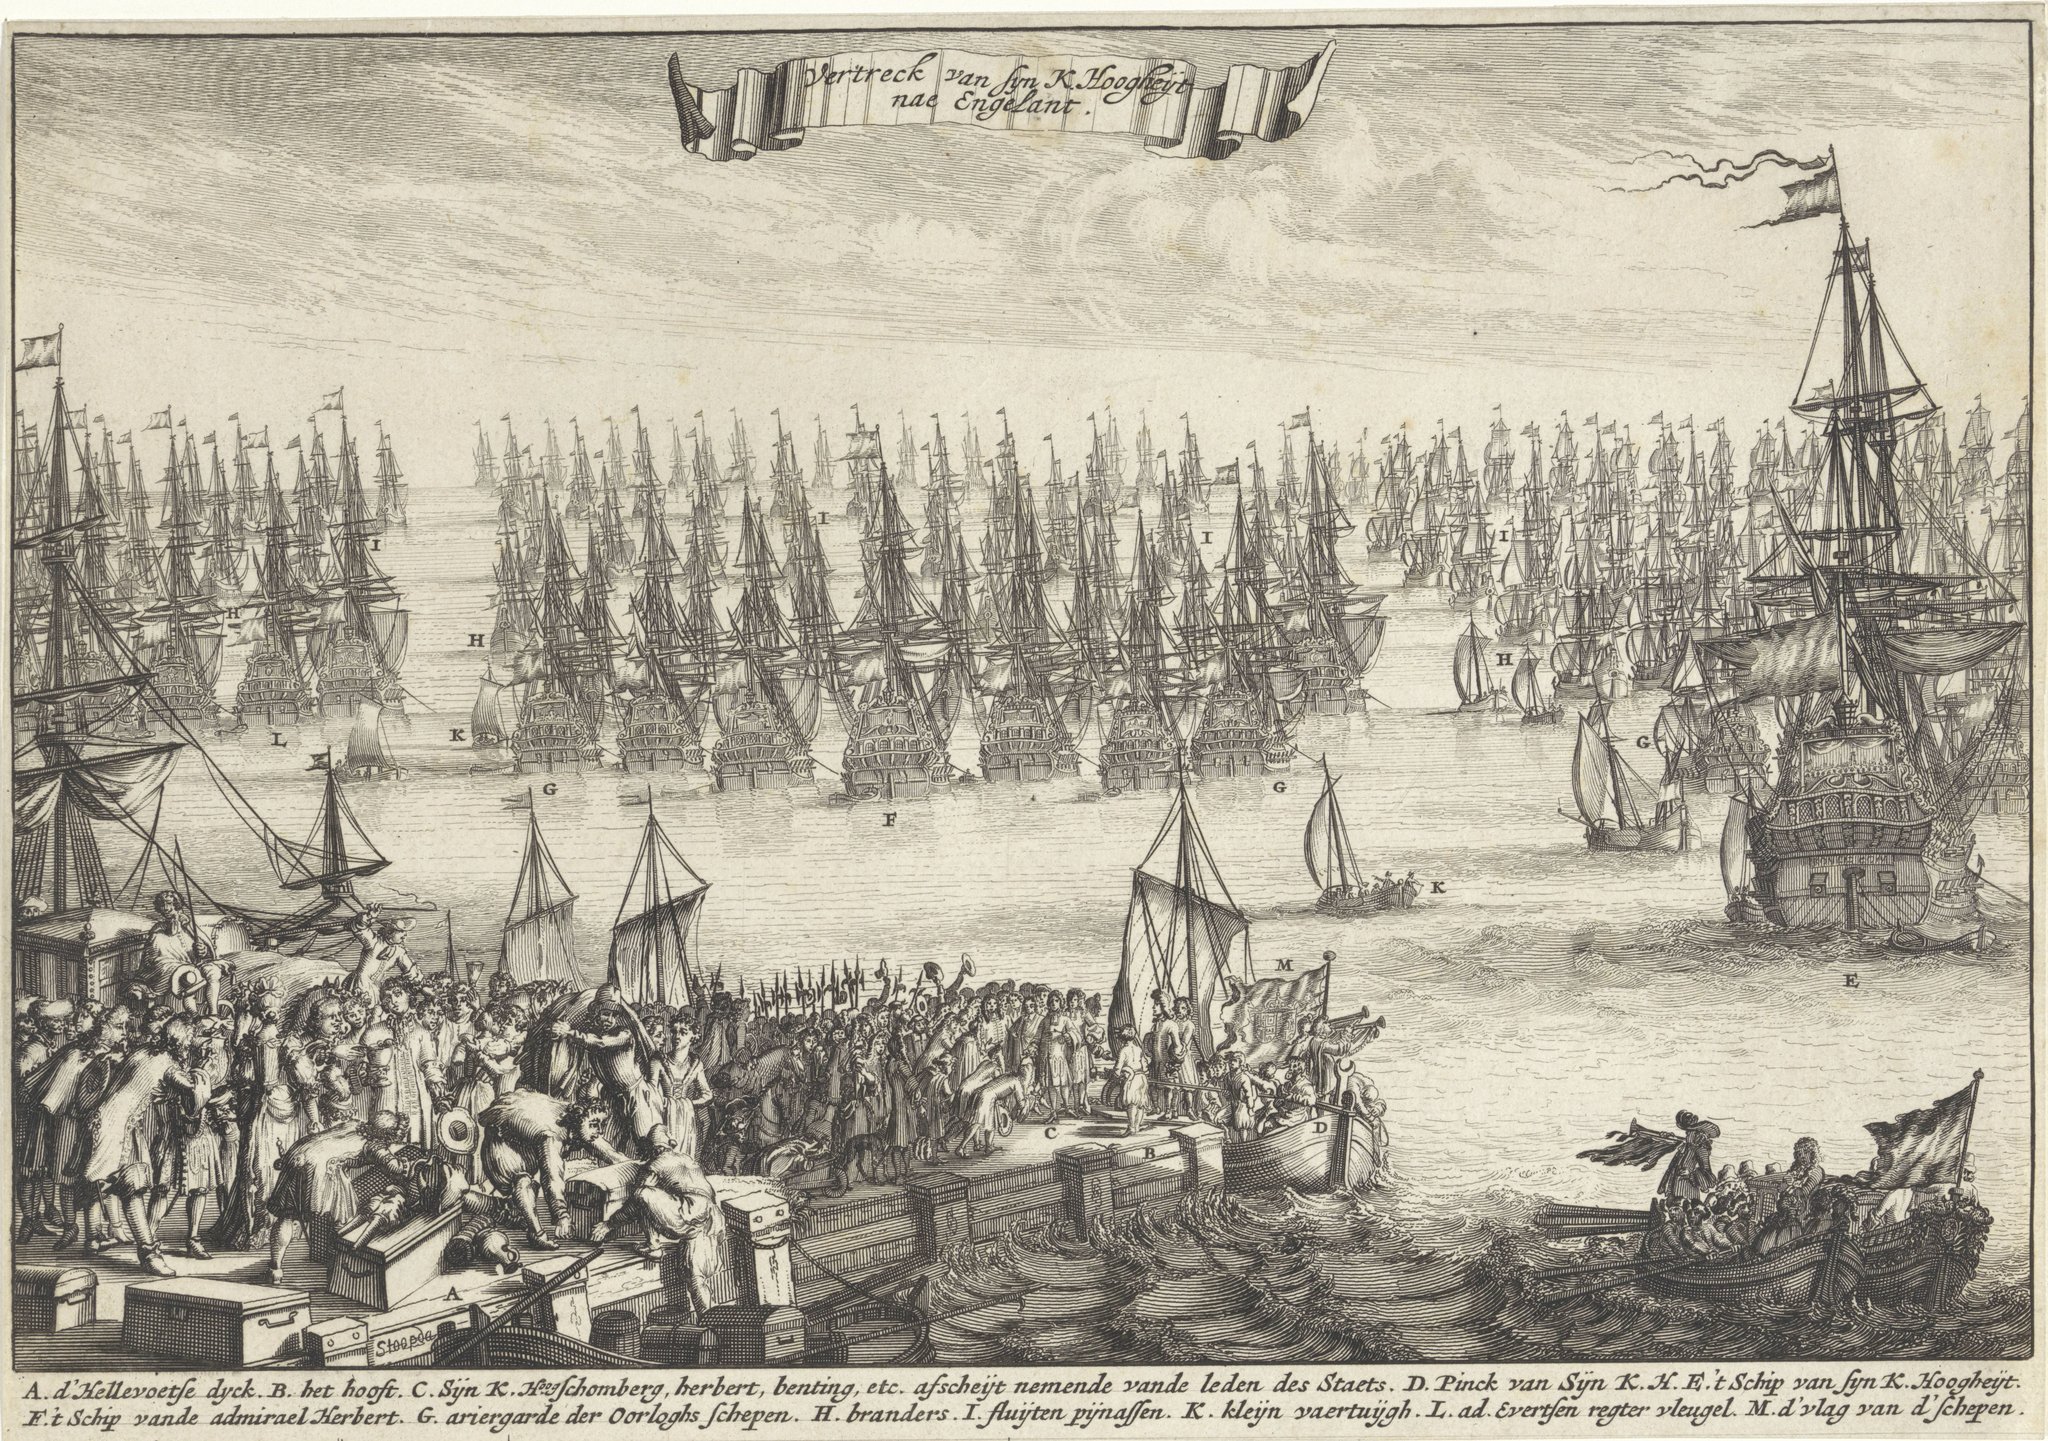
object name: print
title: Vertreck van syn K. Hoogheyt nae Engelant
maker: bastiaen stopendael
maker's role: print maker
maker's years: 1636-1693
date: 1689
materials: paper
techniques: engraving, etching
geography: amsterdam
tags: the hague, william iii (prince of orange and king of england, scotland, and ireland), departure ~ travelling, hellevoetsluis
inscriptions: collector's mark: Lugt 2228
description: Het vertrek van prins Willem III vanuit Hellevoetsluis naar Engeland, 11 november 1688. De prins neemt afscheid staande op de pier, een grote vloot schepen ligt voor de kust voor anker. In het onderschrift de legenda A-M.